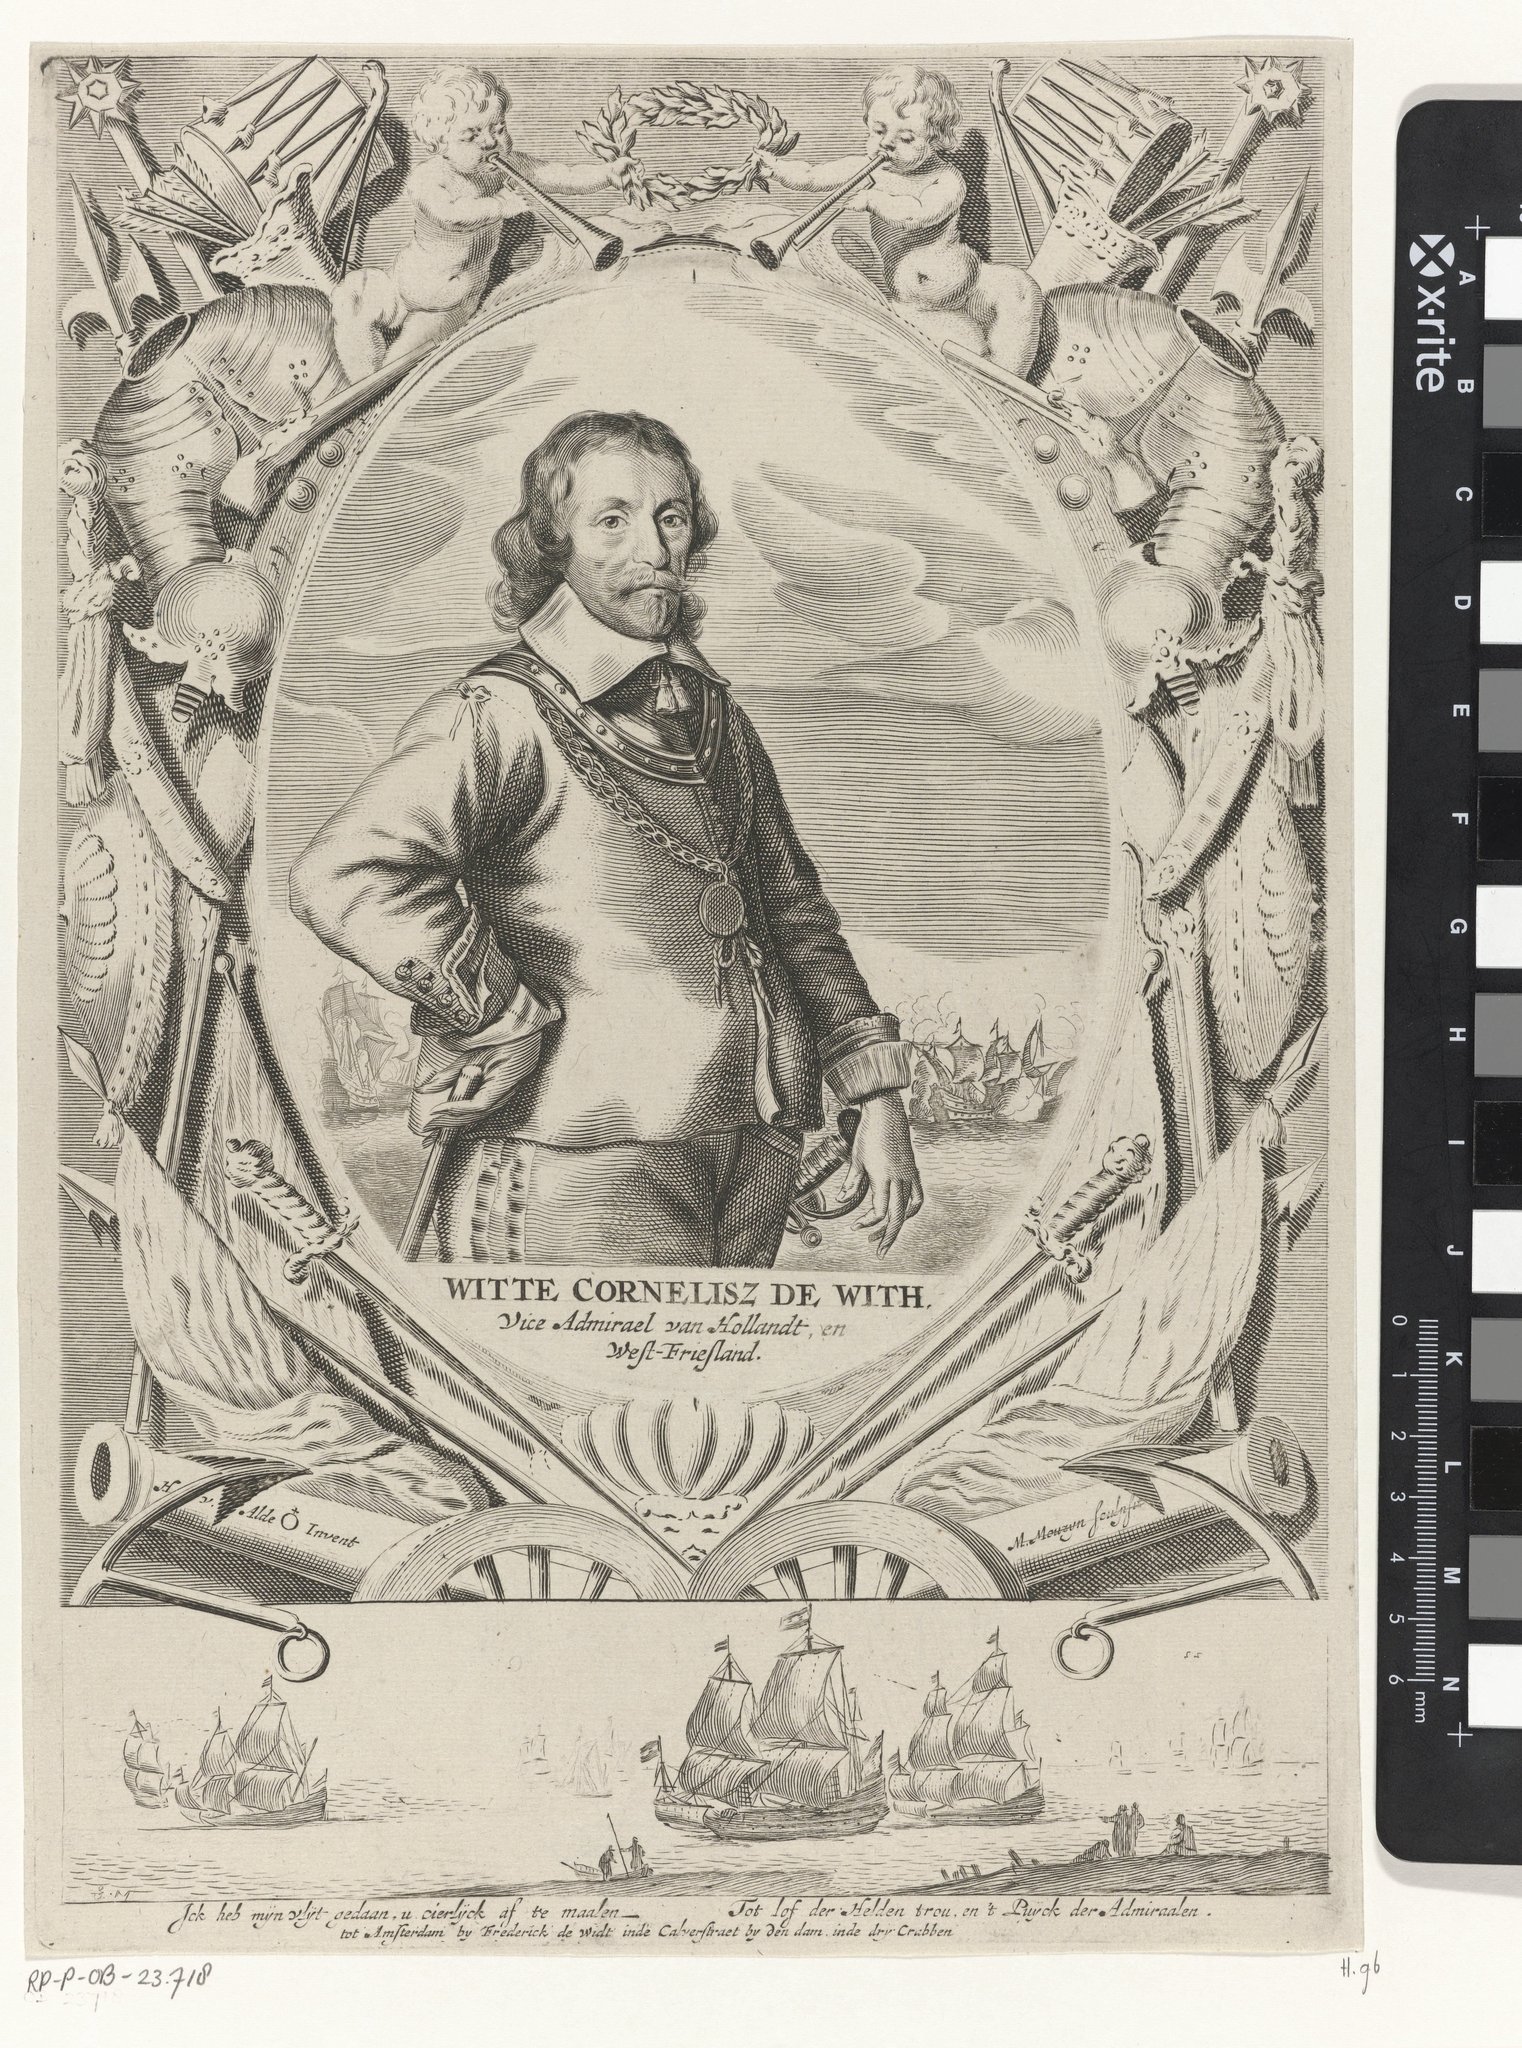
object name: print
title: Portret van Witte Cornelisz. de With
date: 1640-1655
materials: paper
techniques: engraving, etching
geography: amsterdam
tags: navy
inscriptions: collector's mark: Lugt 2228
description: Portret van viceadmiraal Witte Cornelisz. de With voor een zeegezicht met oorlogschepen. Het portret is gevat in ornamentele lijst met vlaggen, zwaarden, kanonnen, harnasdelen en wordt bekroond door twee putti, die een lauwerkrans ophouden. Onderaan in de marge een zeegezicht met zeilschepen.